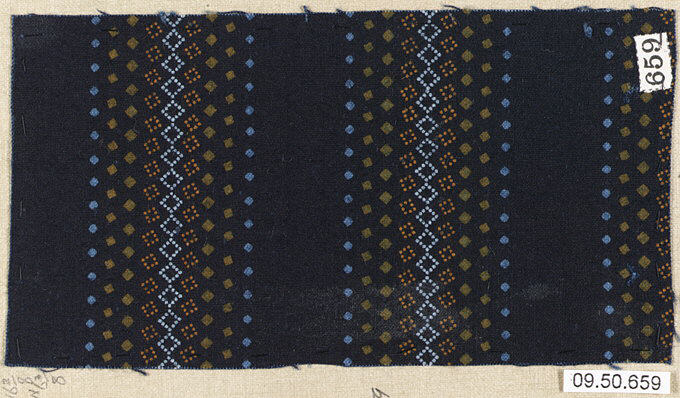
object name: piece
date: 1801-1900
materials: cotton